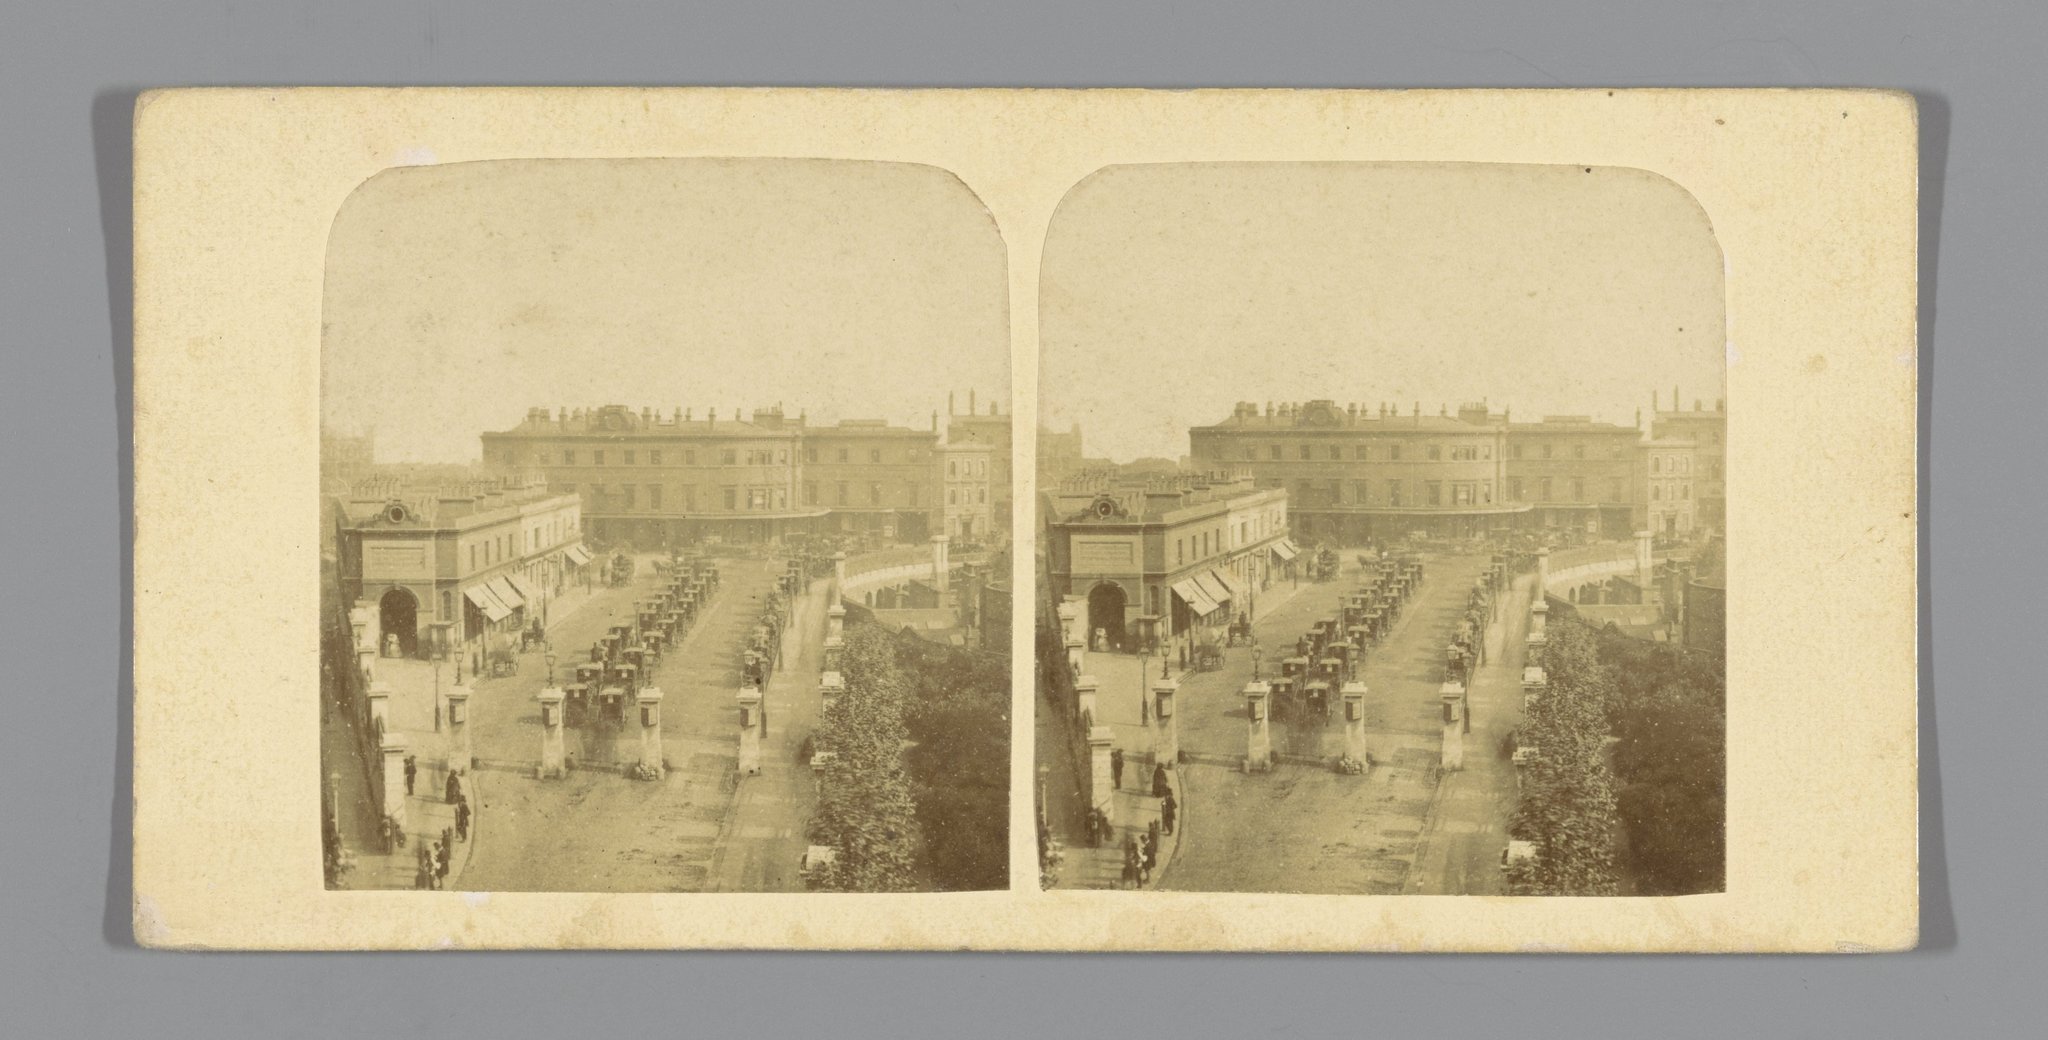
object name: stereograph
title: Views of London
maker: Anonymous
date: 1850-1880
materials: cardboard, photographic support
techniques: albumen print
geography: london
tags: railway, tramway; rack railway, london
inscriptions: number: ‘6.’, number: ‘79. N. 4 t 7’